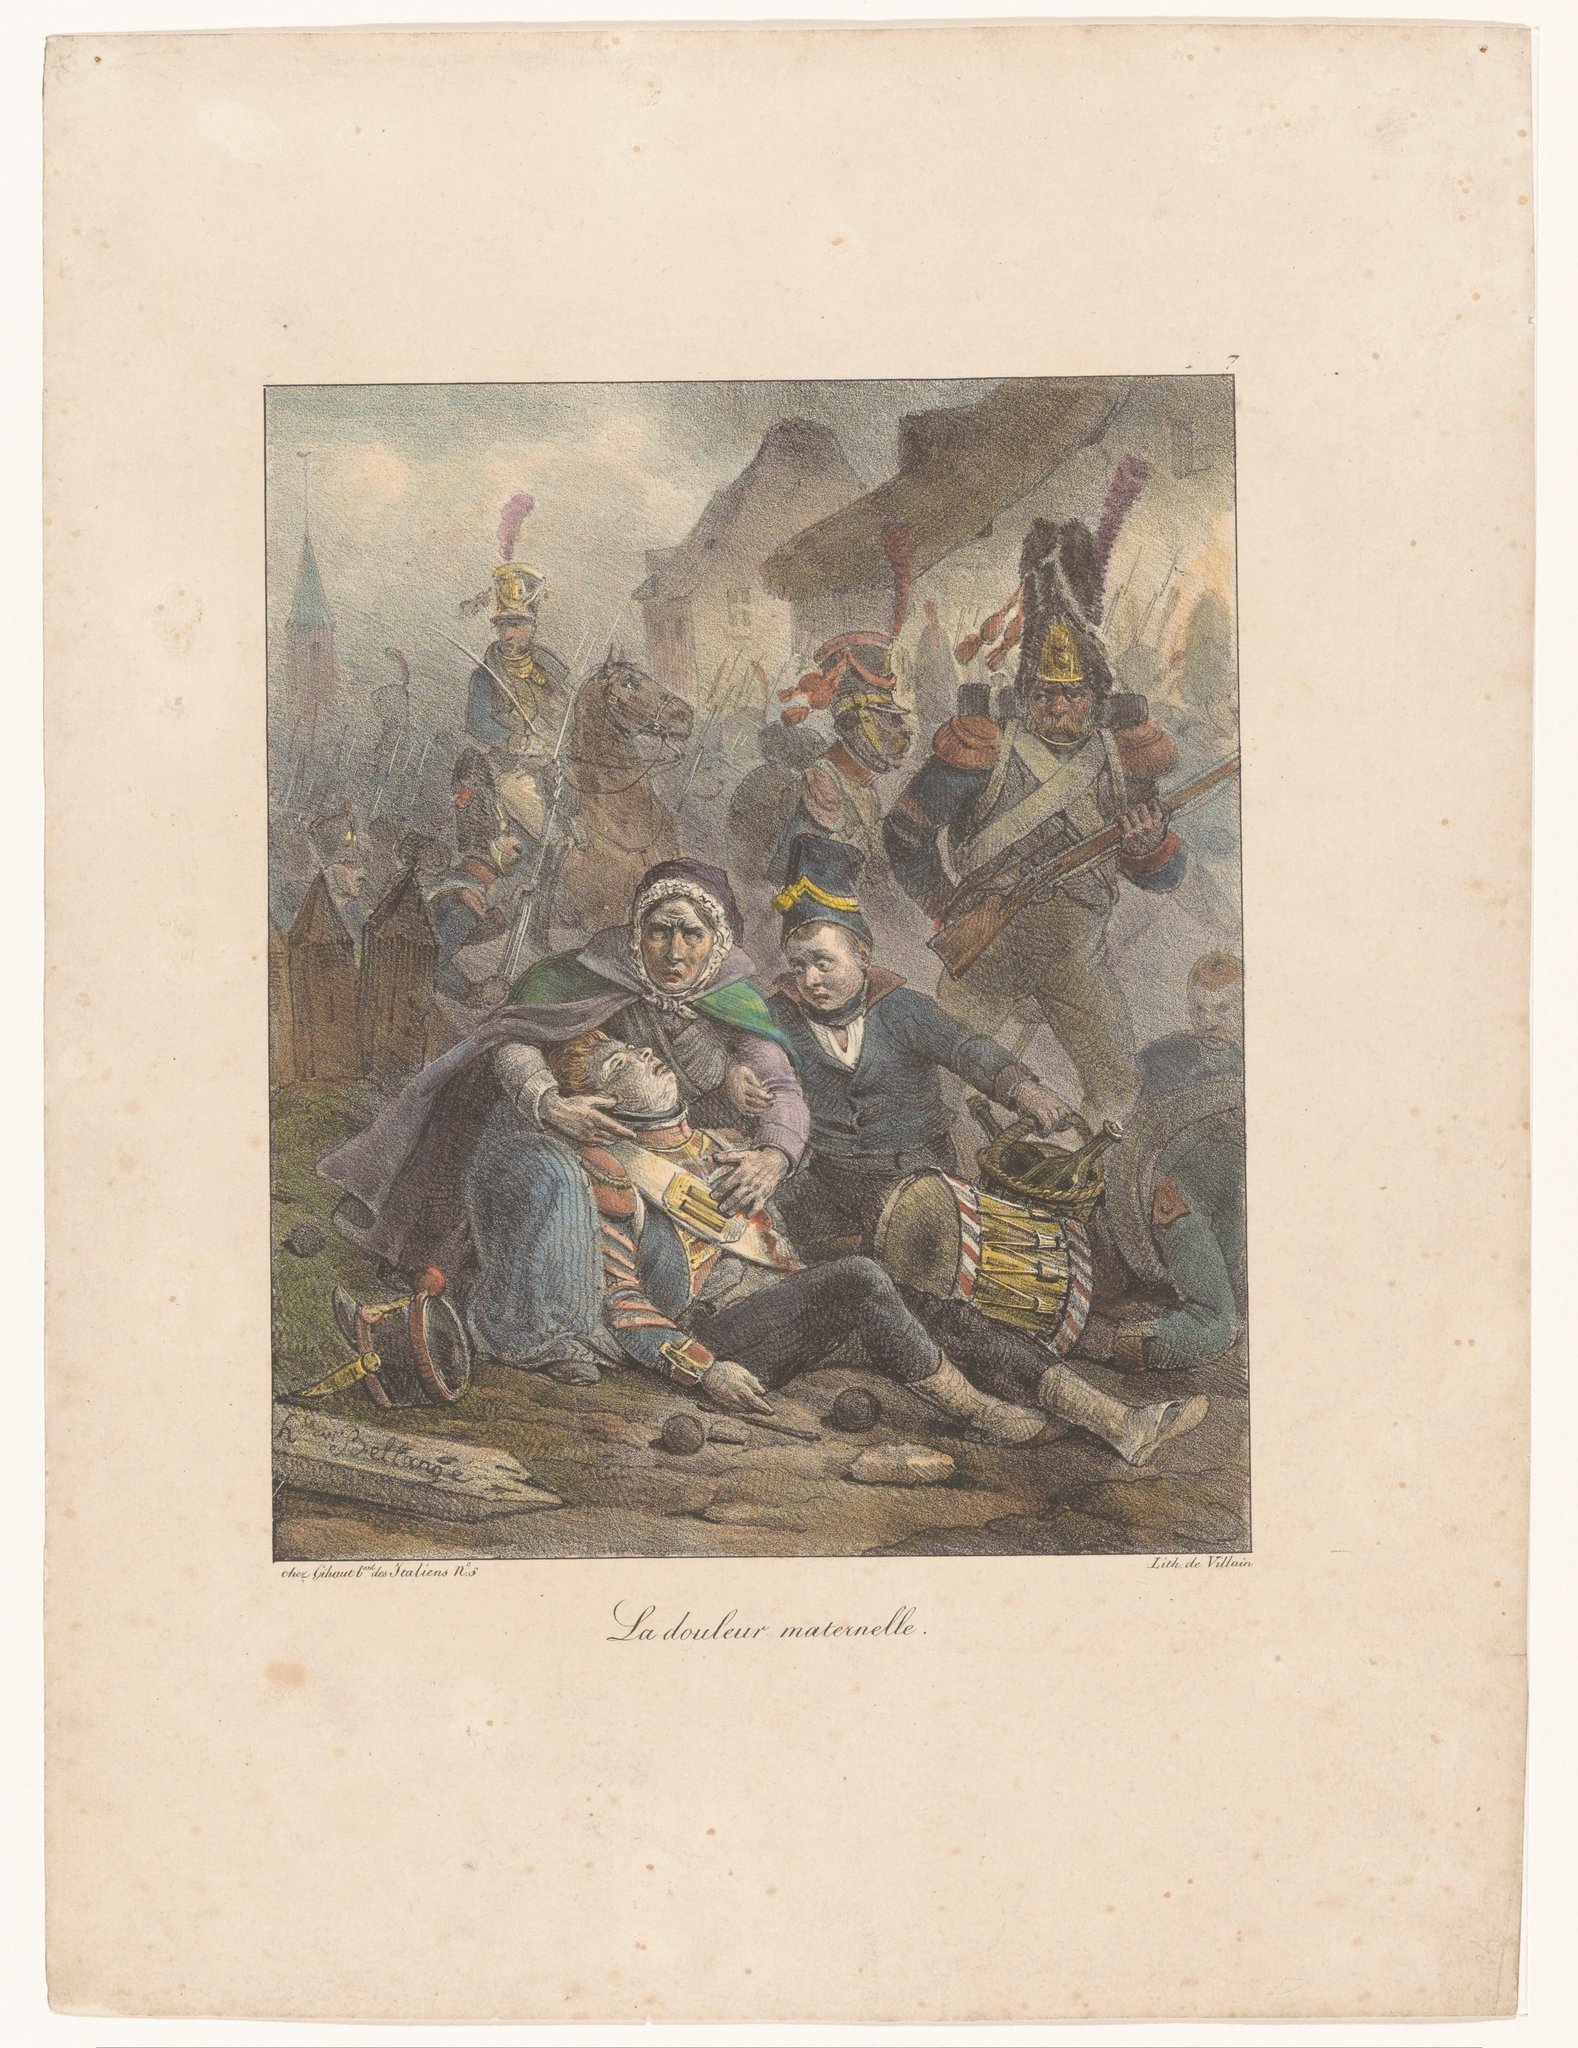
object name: print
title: La douleur maternelle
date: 1823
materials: paper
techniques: hand coloring, lithograph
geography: paris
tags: army 'en route', mother with son(s) (mother-love), mourning the dead, violent death by firearms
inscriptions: collector's mark: Lugt 2228a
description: Naast de gewonde tamboer ligt zijn trommel. Het bloed stroomt uit zijn borst op de plek waar zijn moeder haar linkerhand houdt. De jongere zoon pakt zijn moeder bij de arm.